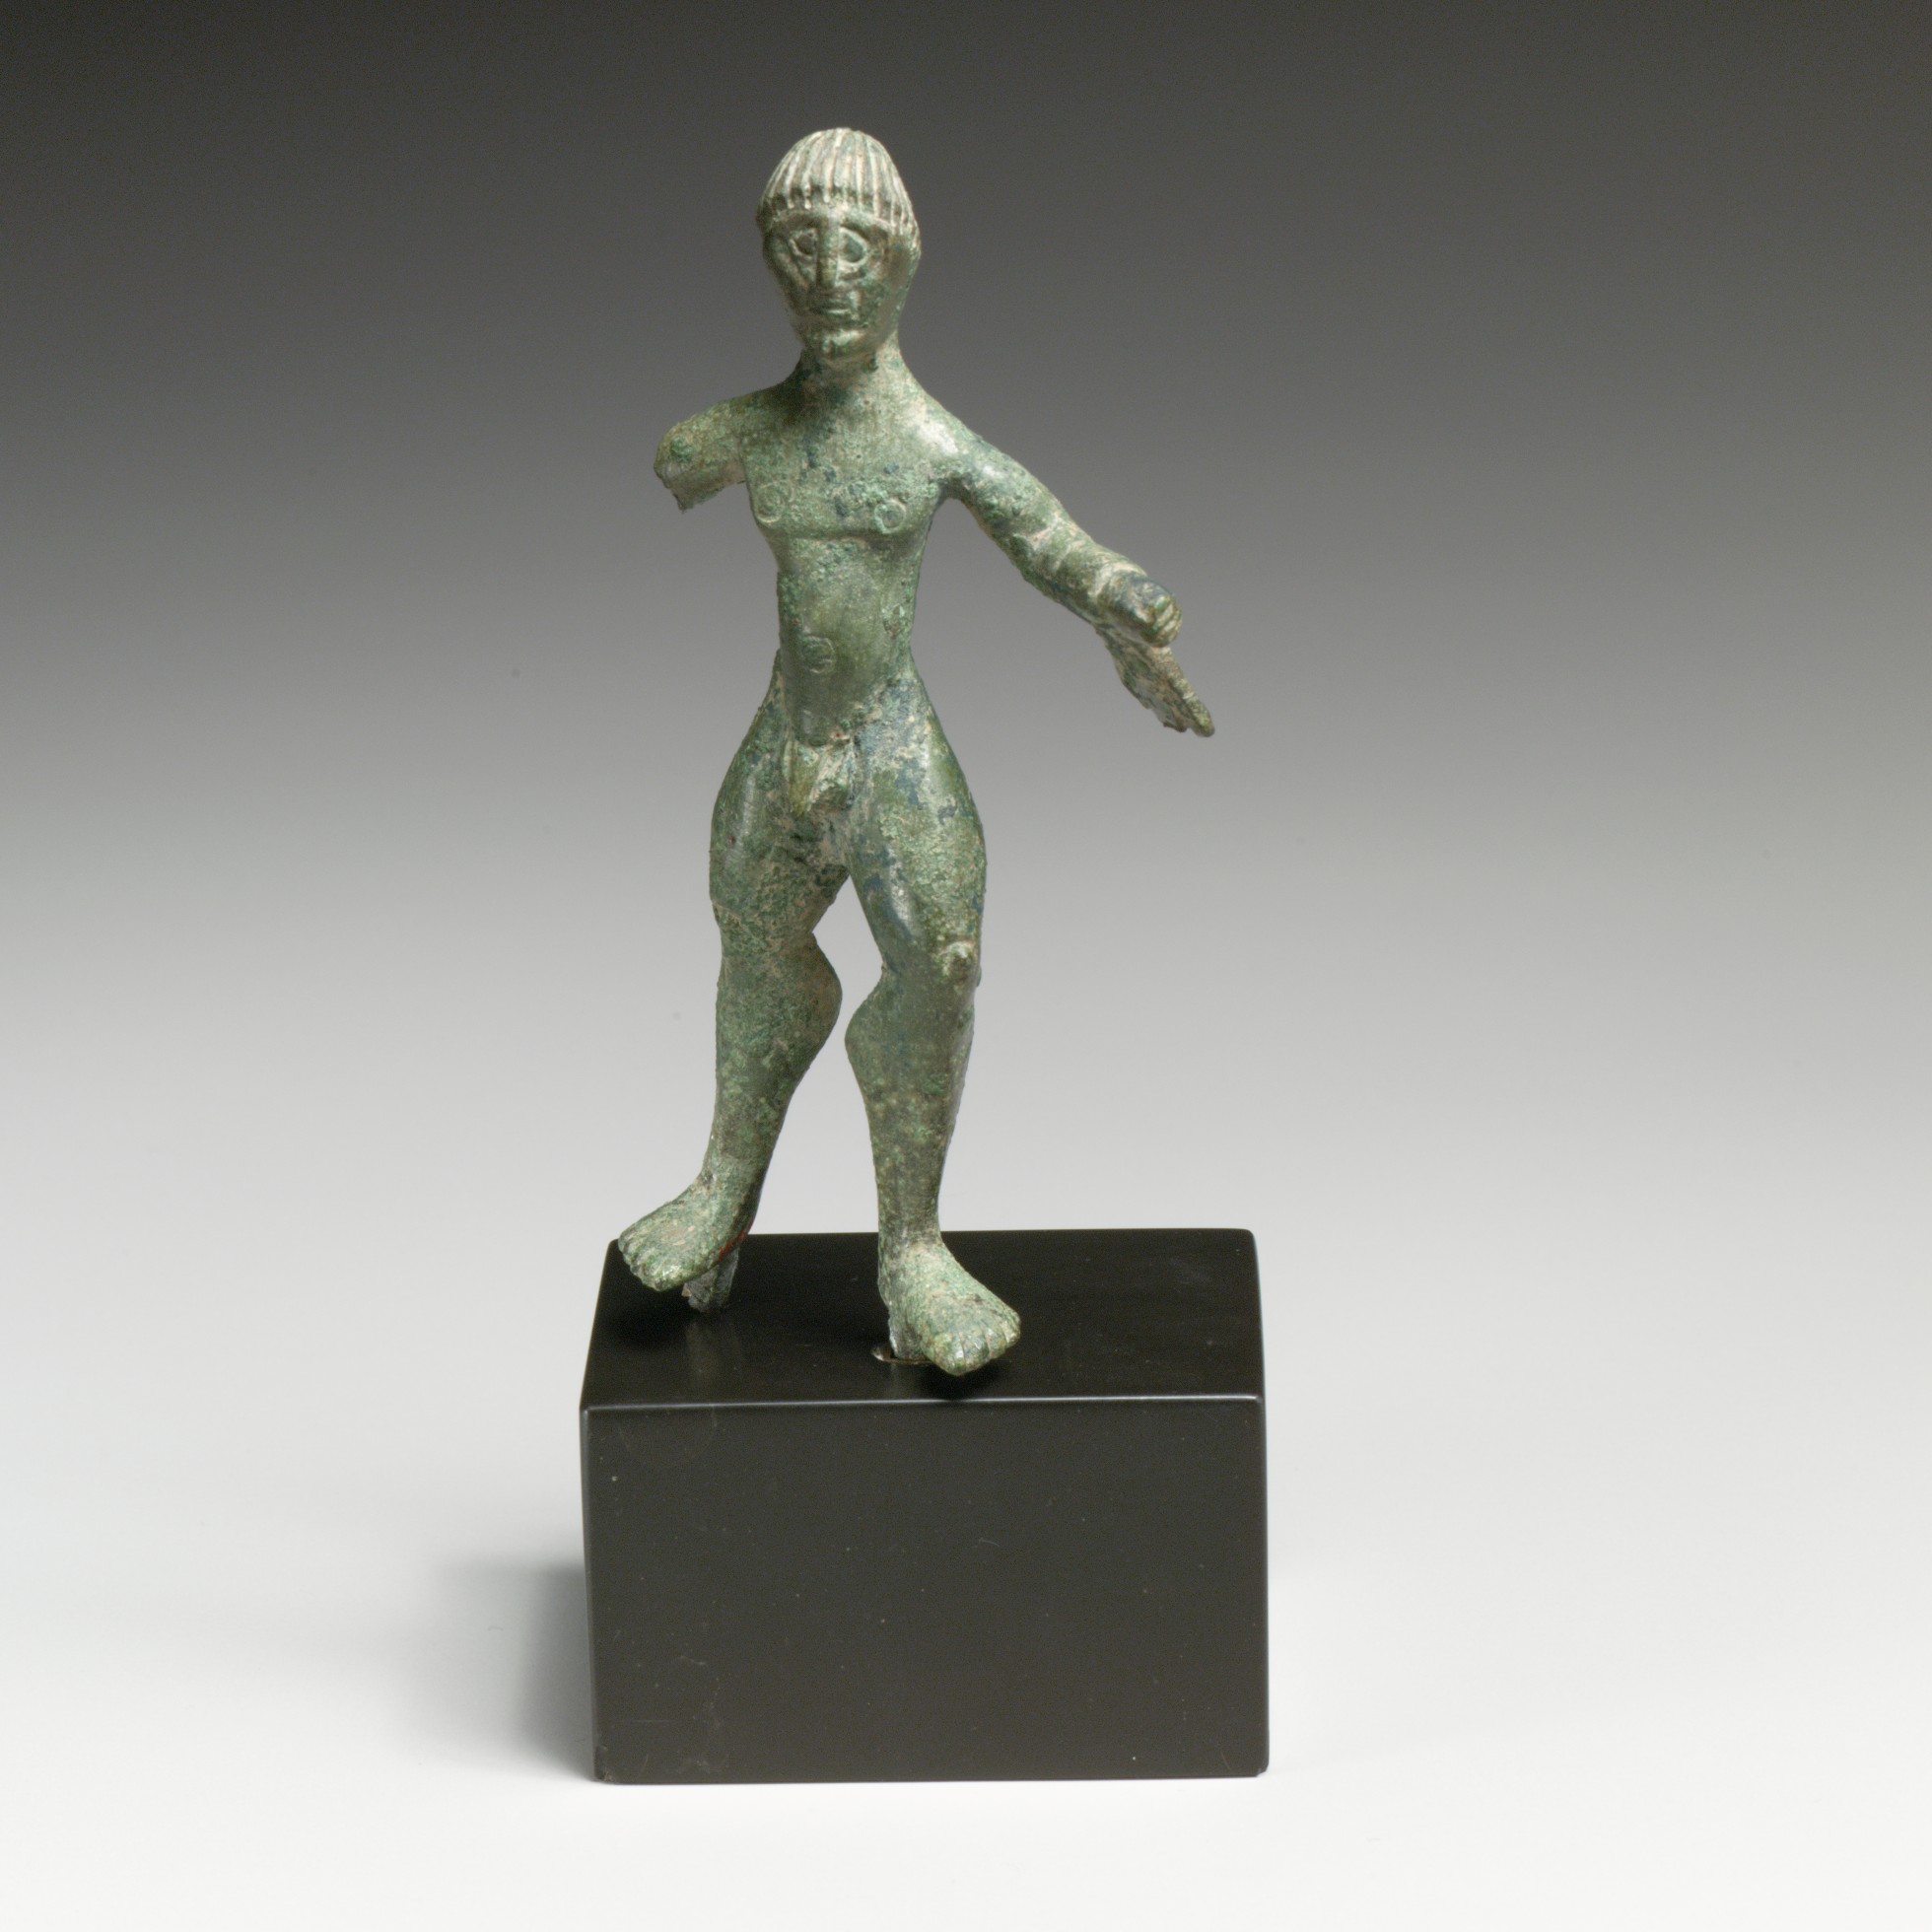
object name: statuette of herakles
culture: etruscan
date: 401-500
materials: bronze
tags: male nudes,herakles